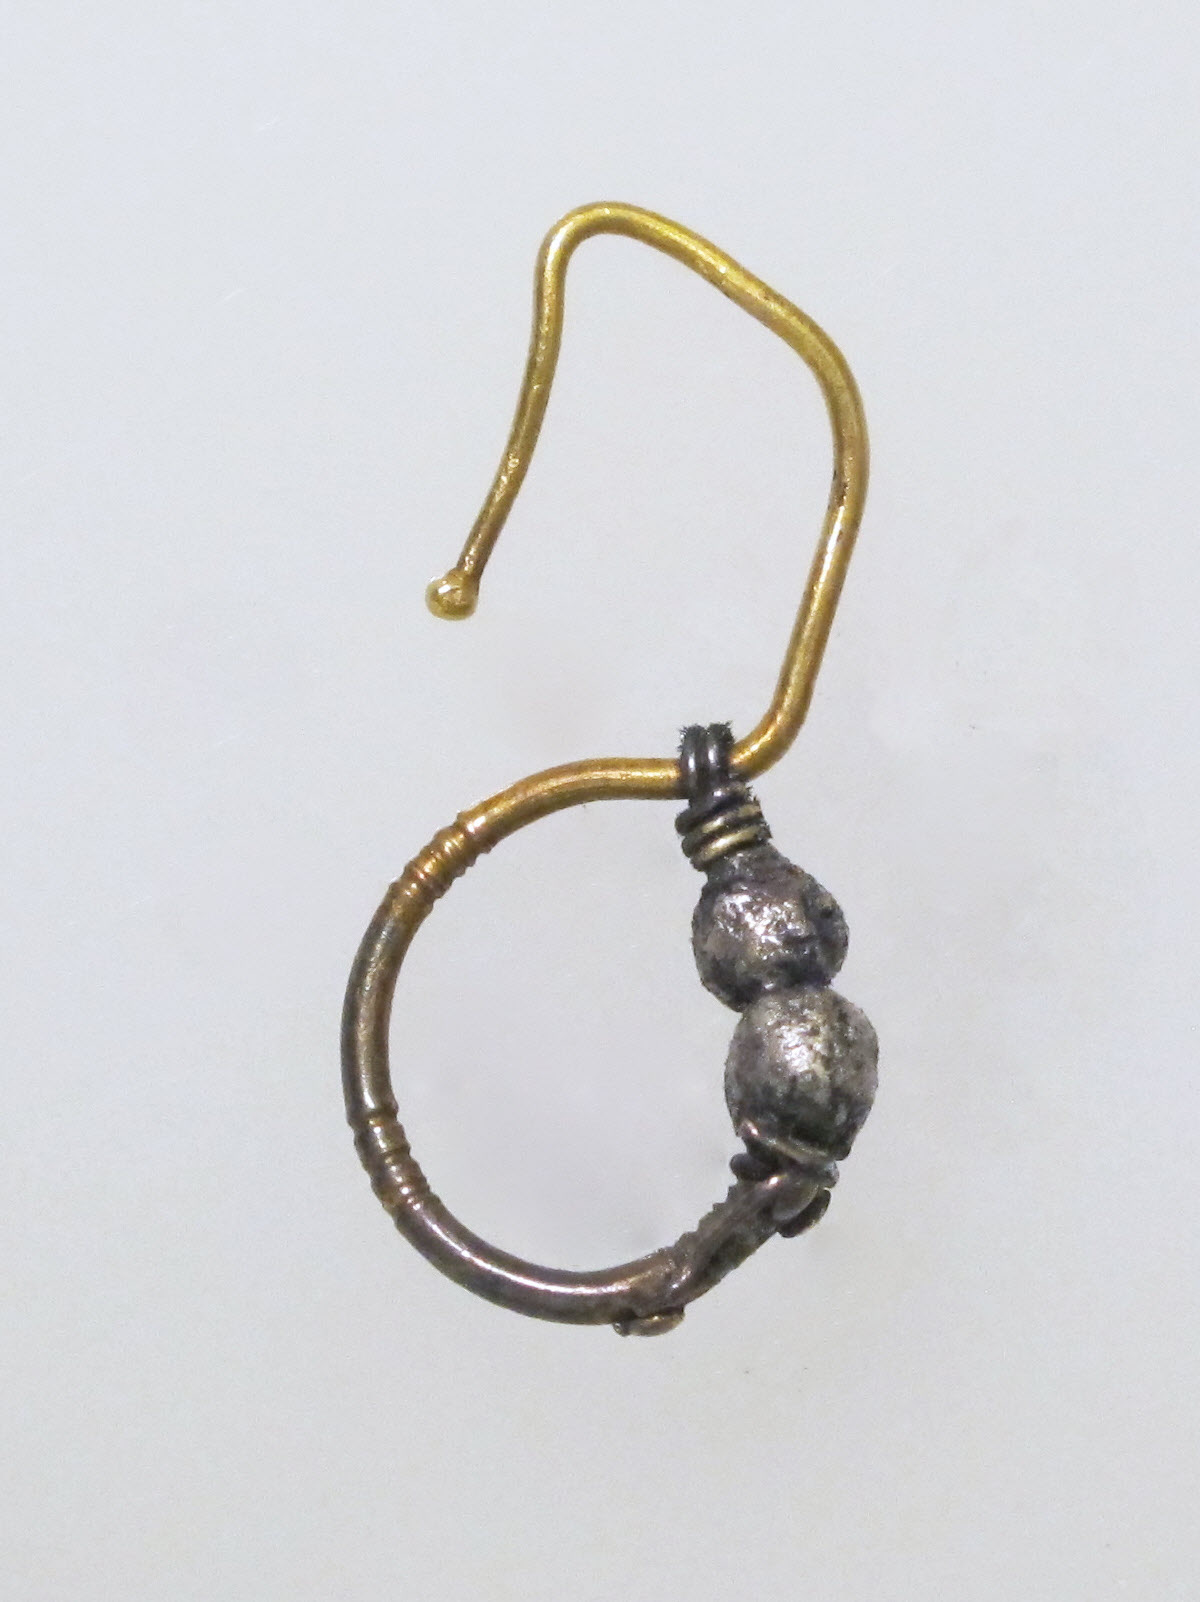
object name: earring, delta shaped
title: Earring, delta-shaped with beads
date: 7000 BCE-330 CE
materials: gold, silver